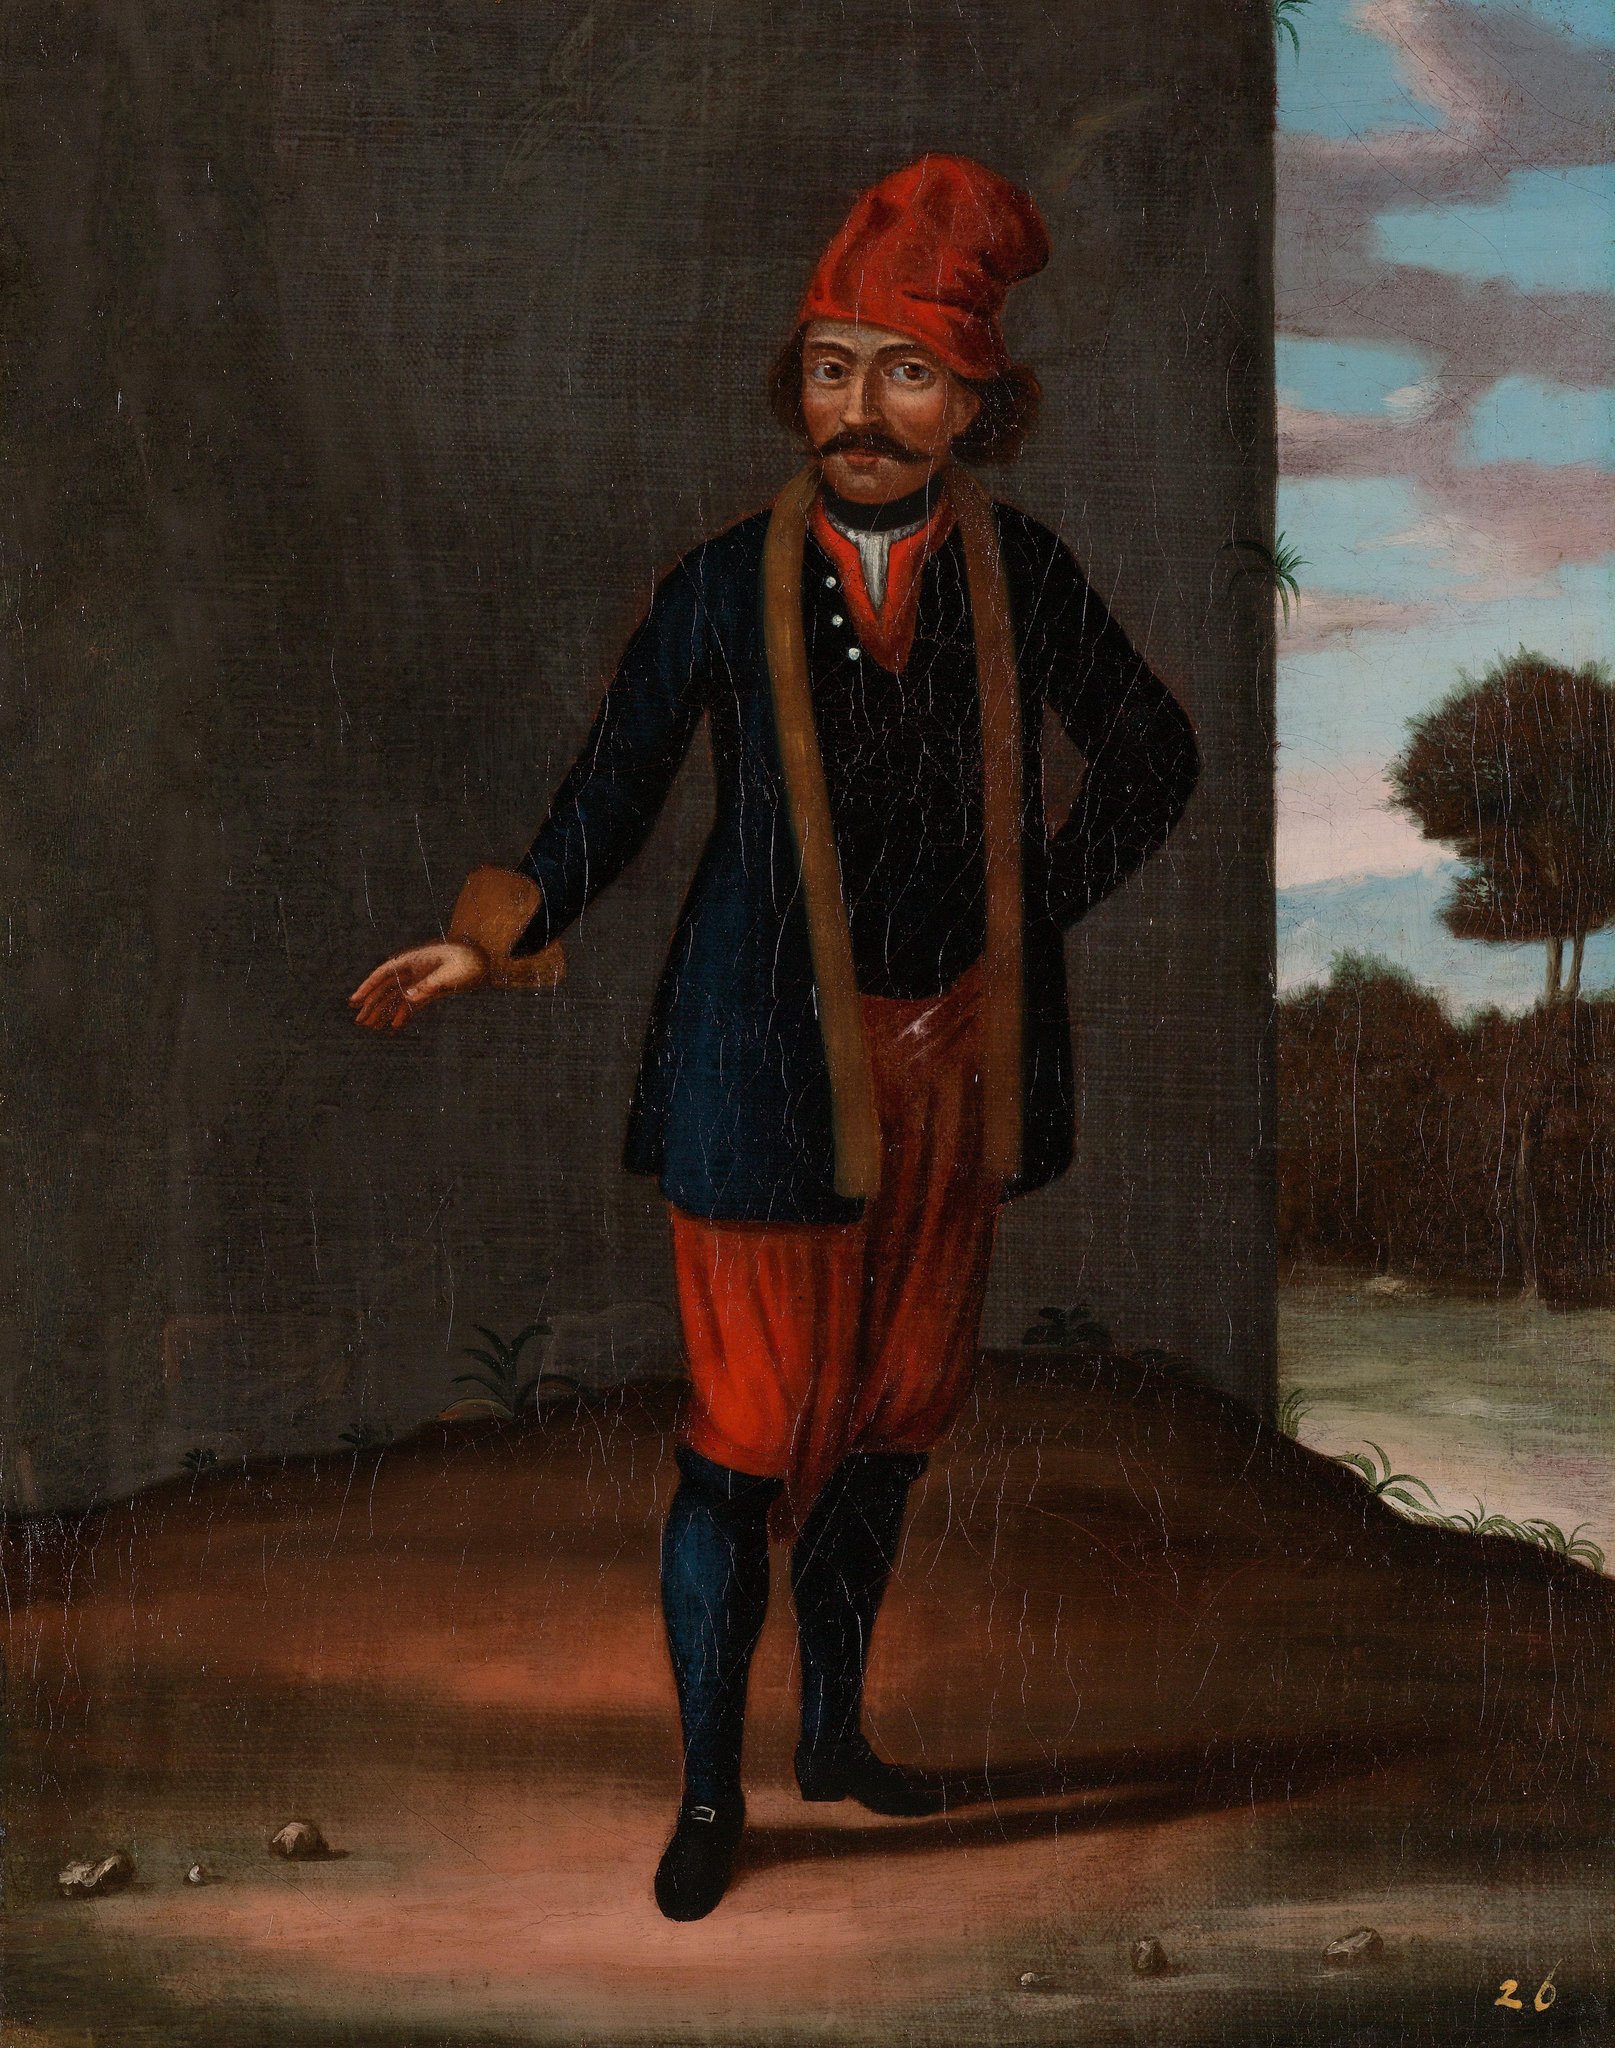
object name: painting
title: Man from the Island of Kithnos (Thermia)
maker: jean baptiste vanmour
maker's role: painter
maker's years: 1671-1737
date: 1700-1737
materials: canvas, oil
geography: istanbul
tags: standing figure, folk costume, regional costume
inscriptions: number: ‘26’, inscription: ‘Termiote / Een man van het eiland Termio’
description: Een man van het eiland Kythnos (Thermia). Staande, ten voeten uit, voor een muur.